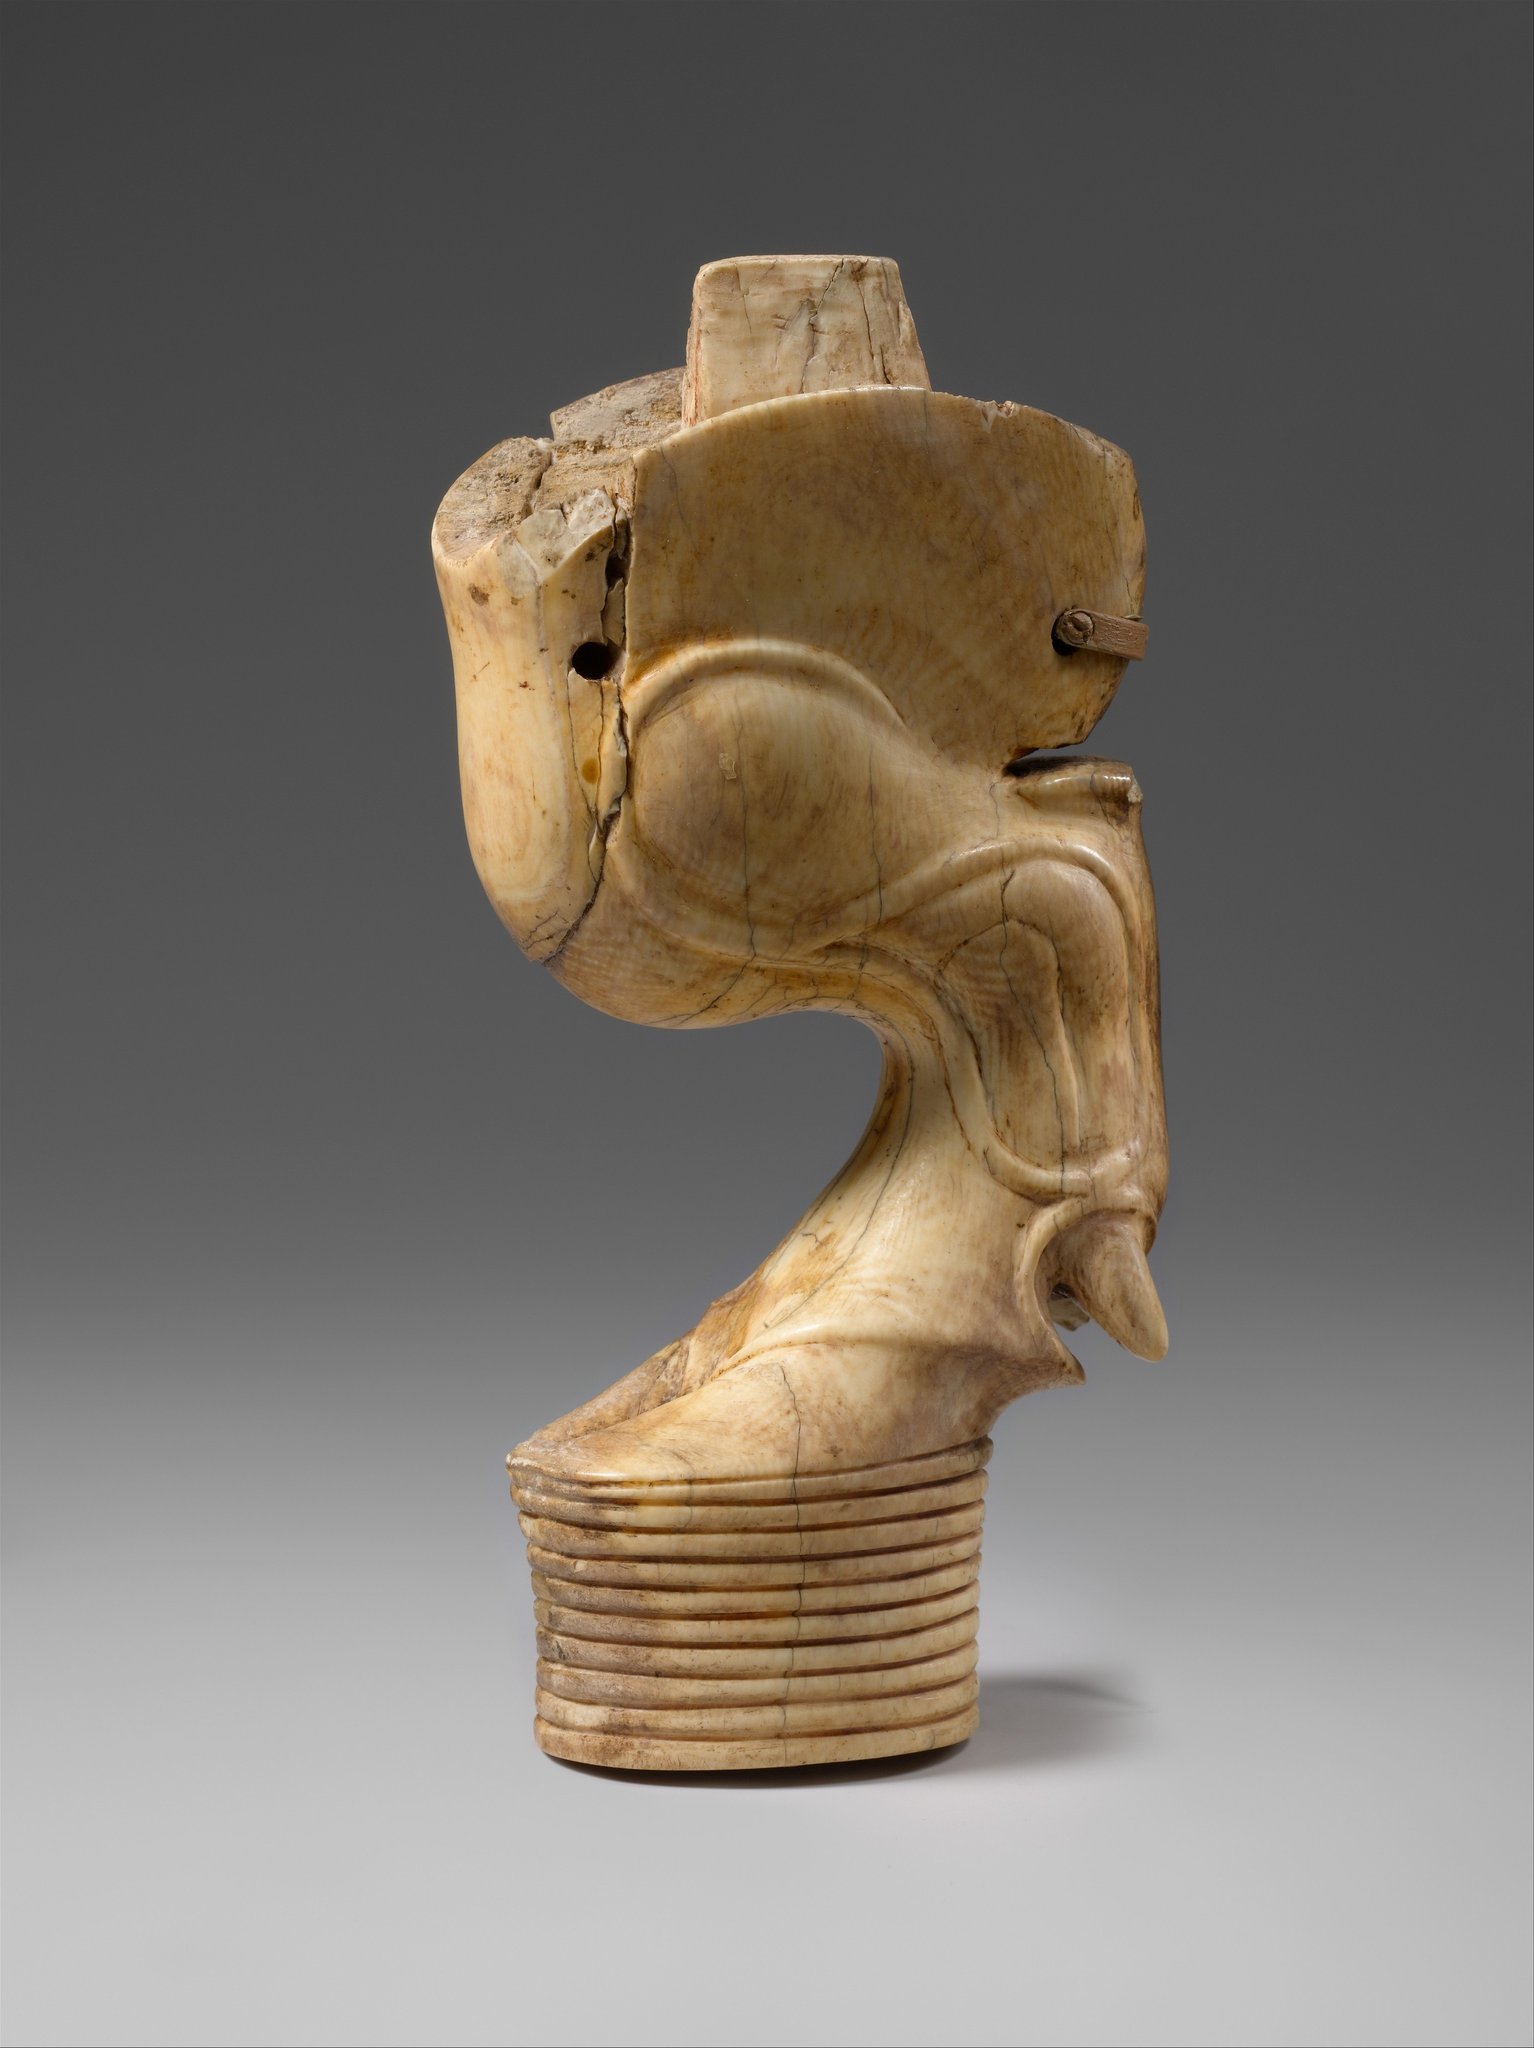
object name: chair or bed leg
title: Leg from a bed or chair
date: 3100-2650 BCE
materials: ivory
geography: egypt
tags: furniture